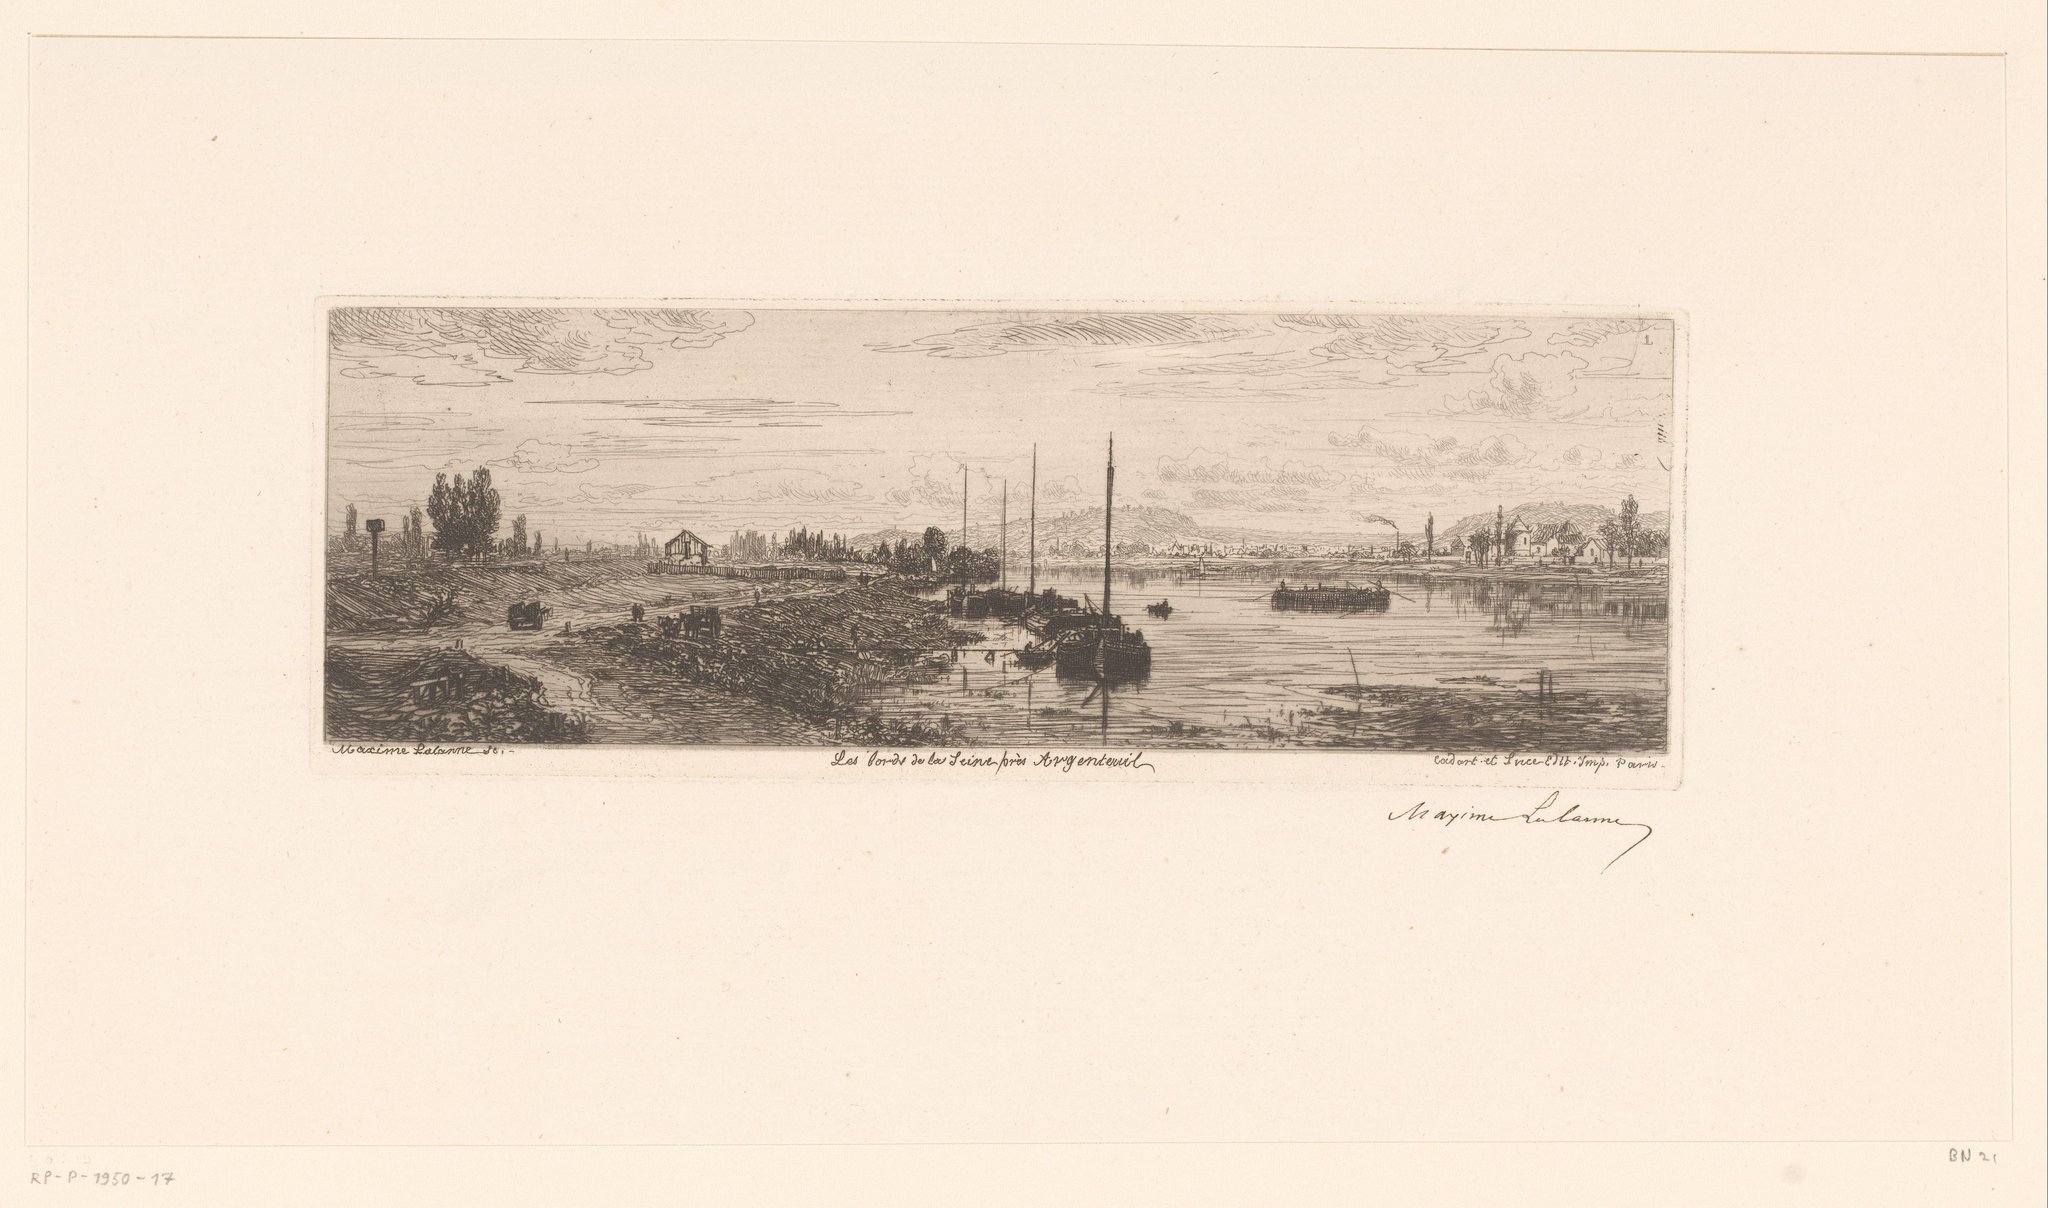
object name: print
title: Les bords de la Seine près Argenteuil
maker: maxime françois antoine lalanne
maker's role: draughtsman, print maker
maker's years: 1827-1886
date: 1869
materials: paper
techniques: drypoint, etching, intaglio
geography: france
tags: landscapes with waters, waterscapes, seascapes (in the temperate zone), ships (in general)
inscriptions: collector's mark: Lugt 2228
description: Gepubliceerd in: "Douze croquis à l'eau-forte (...)".